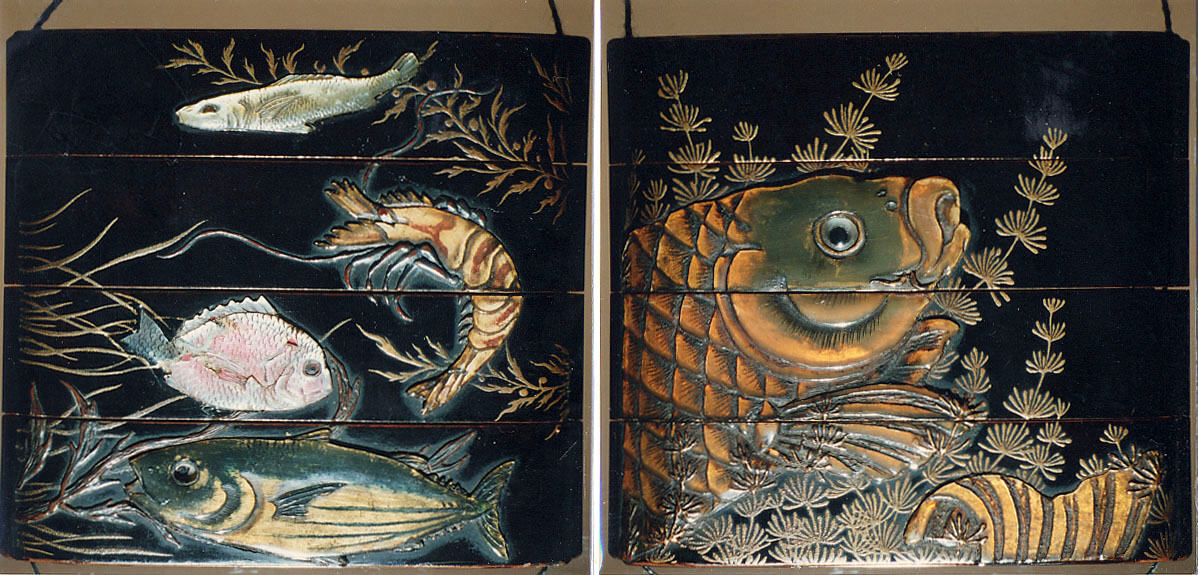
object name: inrō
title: Case (Inrō) with Design of Fish among Seaweeds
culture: japanese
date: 1701-1900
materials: gold, horn, ivory, lacquer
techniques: fundame, hiramakie, roiro, stain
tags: fish,lobsters,plants